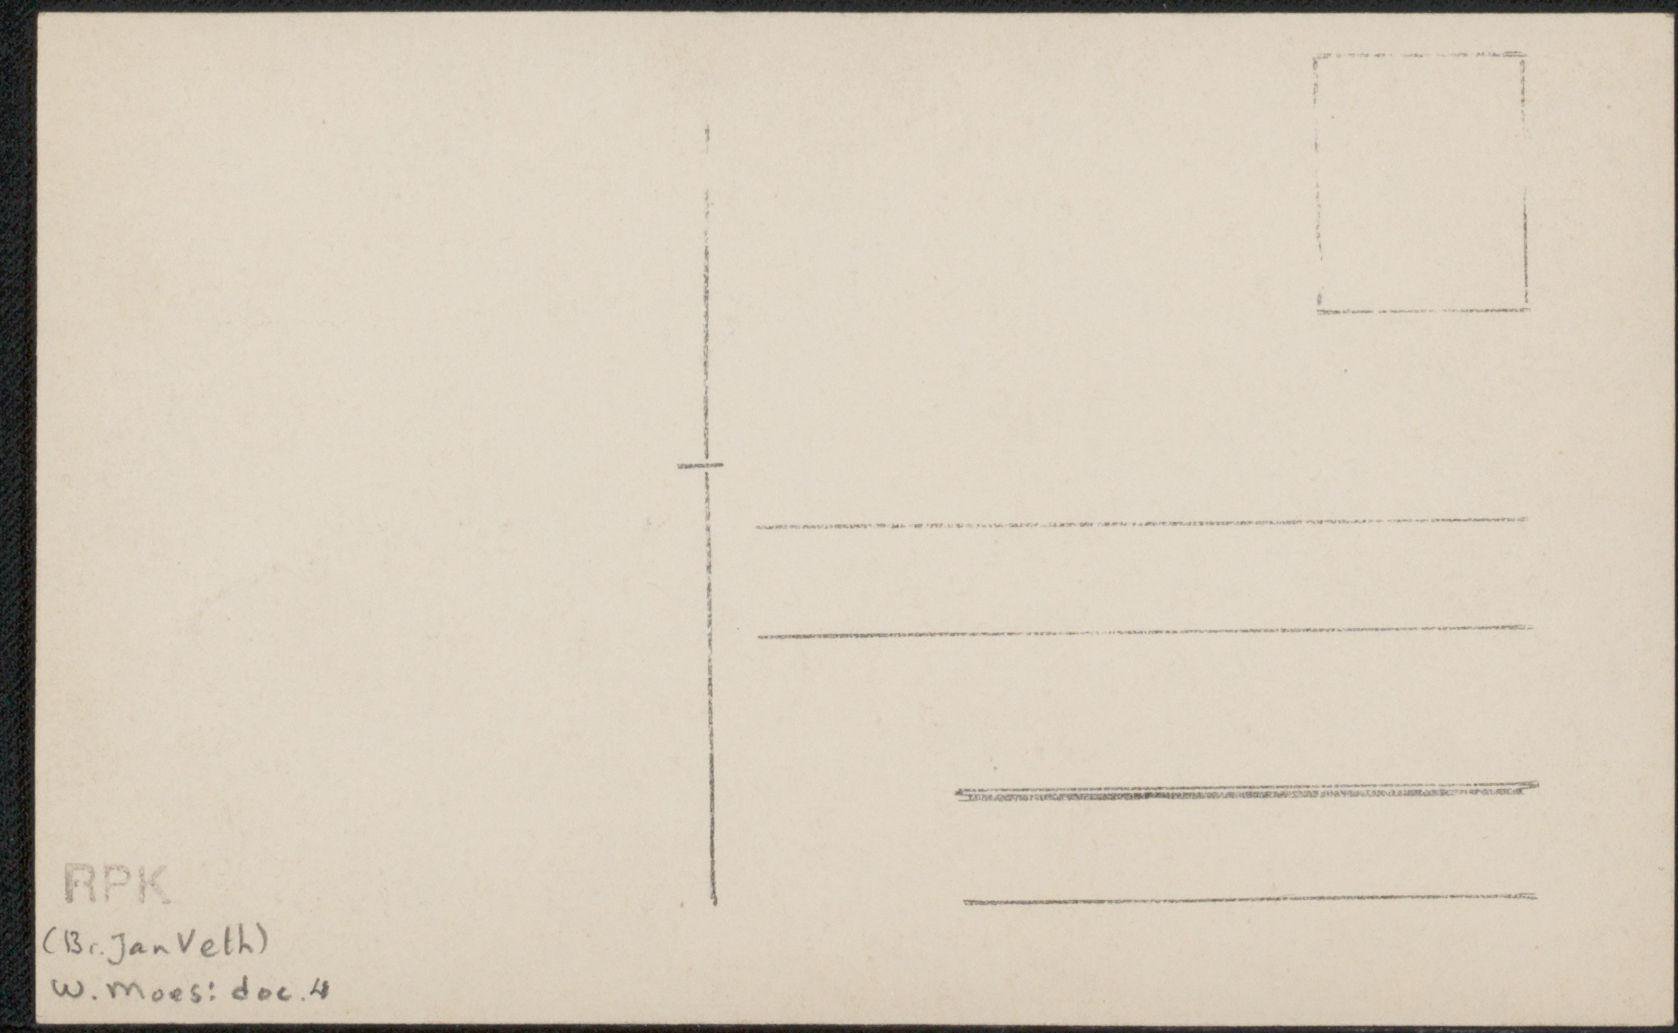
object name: photograph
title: Prentbriefkaart uit archief Jan Veth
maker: Anonymous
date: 1866-1918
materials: photographic support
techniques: gelatin silver print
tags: dordrecht, amsterdam, painter, print maker, draughtsman, designer, jan veth, wally moes, villa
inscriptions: collector's mark: ‘RPK’